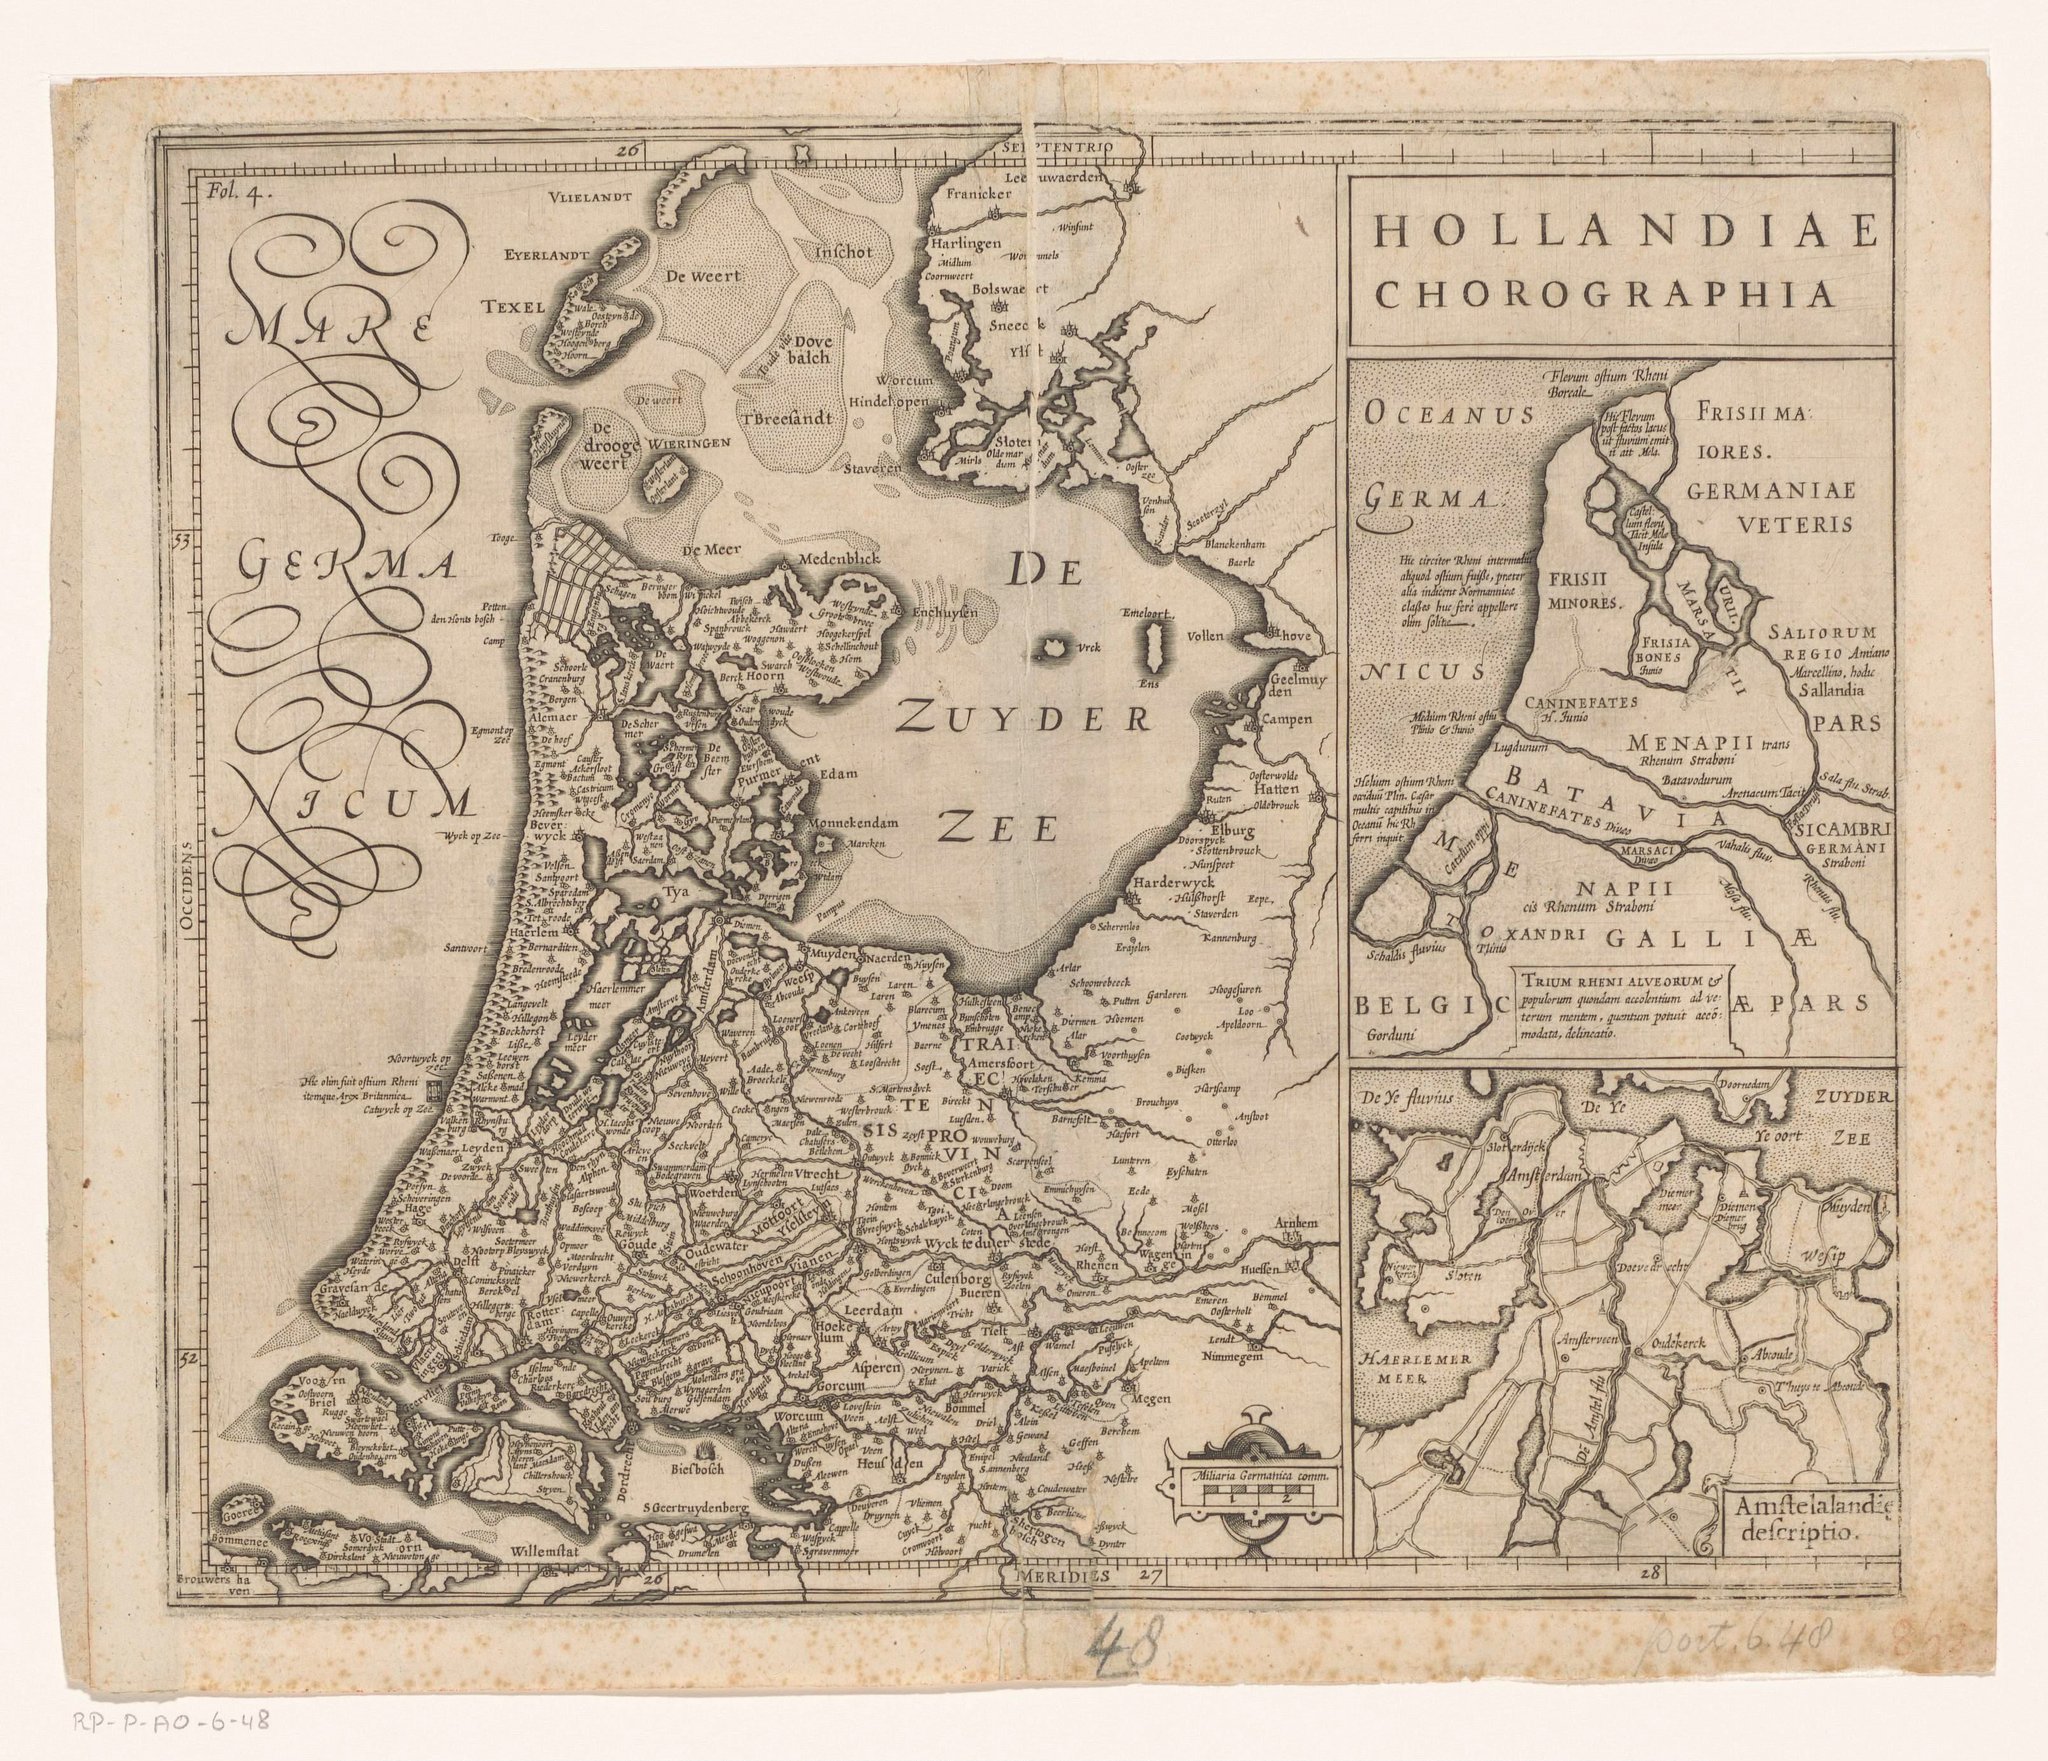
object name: map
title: Hollandia chorographia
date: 1611-1614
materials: paper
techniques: engraving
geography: amsterdam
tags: maps of separate countries or regions, holland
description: Linksonder op de hoofdkaart een schaalstok: Miliaria Germanica comm. Rechtsboven de titel, daaronder een historische inzetkaart van de Nederlanden in de Oudheid, daaronder een inzetkaart van Amstelland. Gradenverdeling langs de randen.